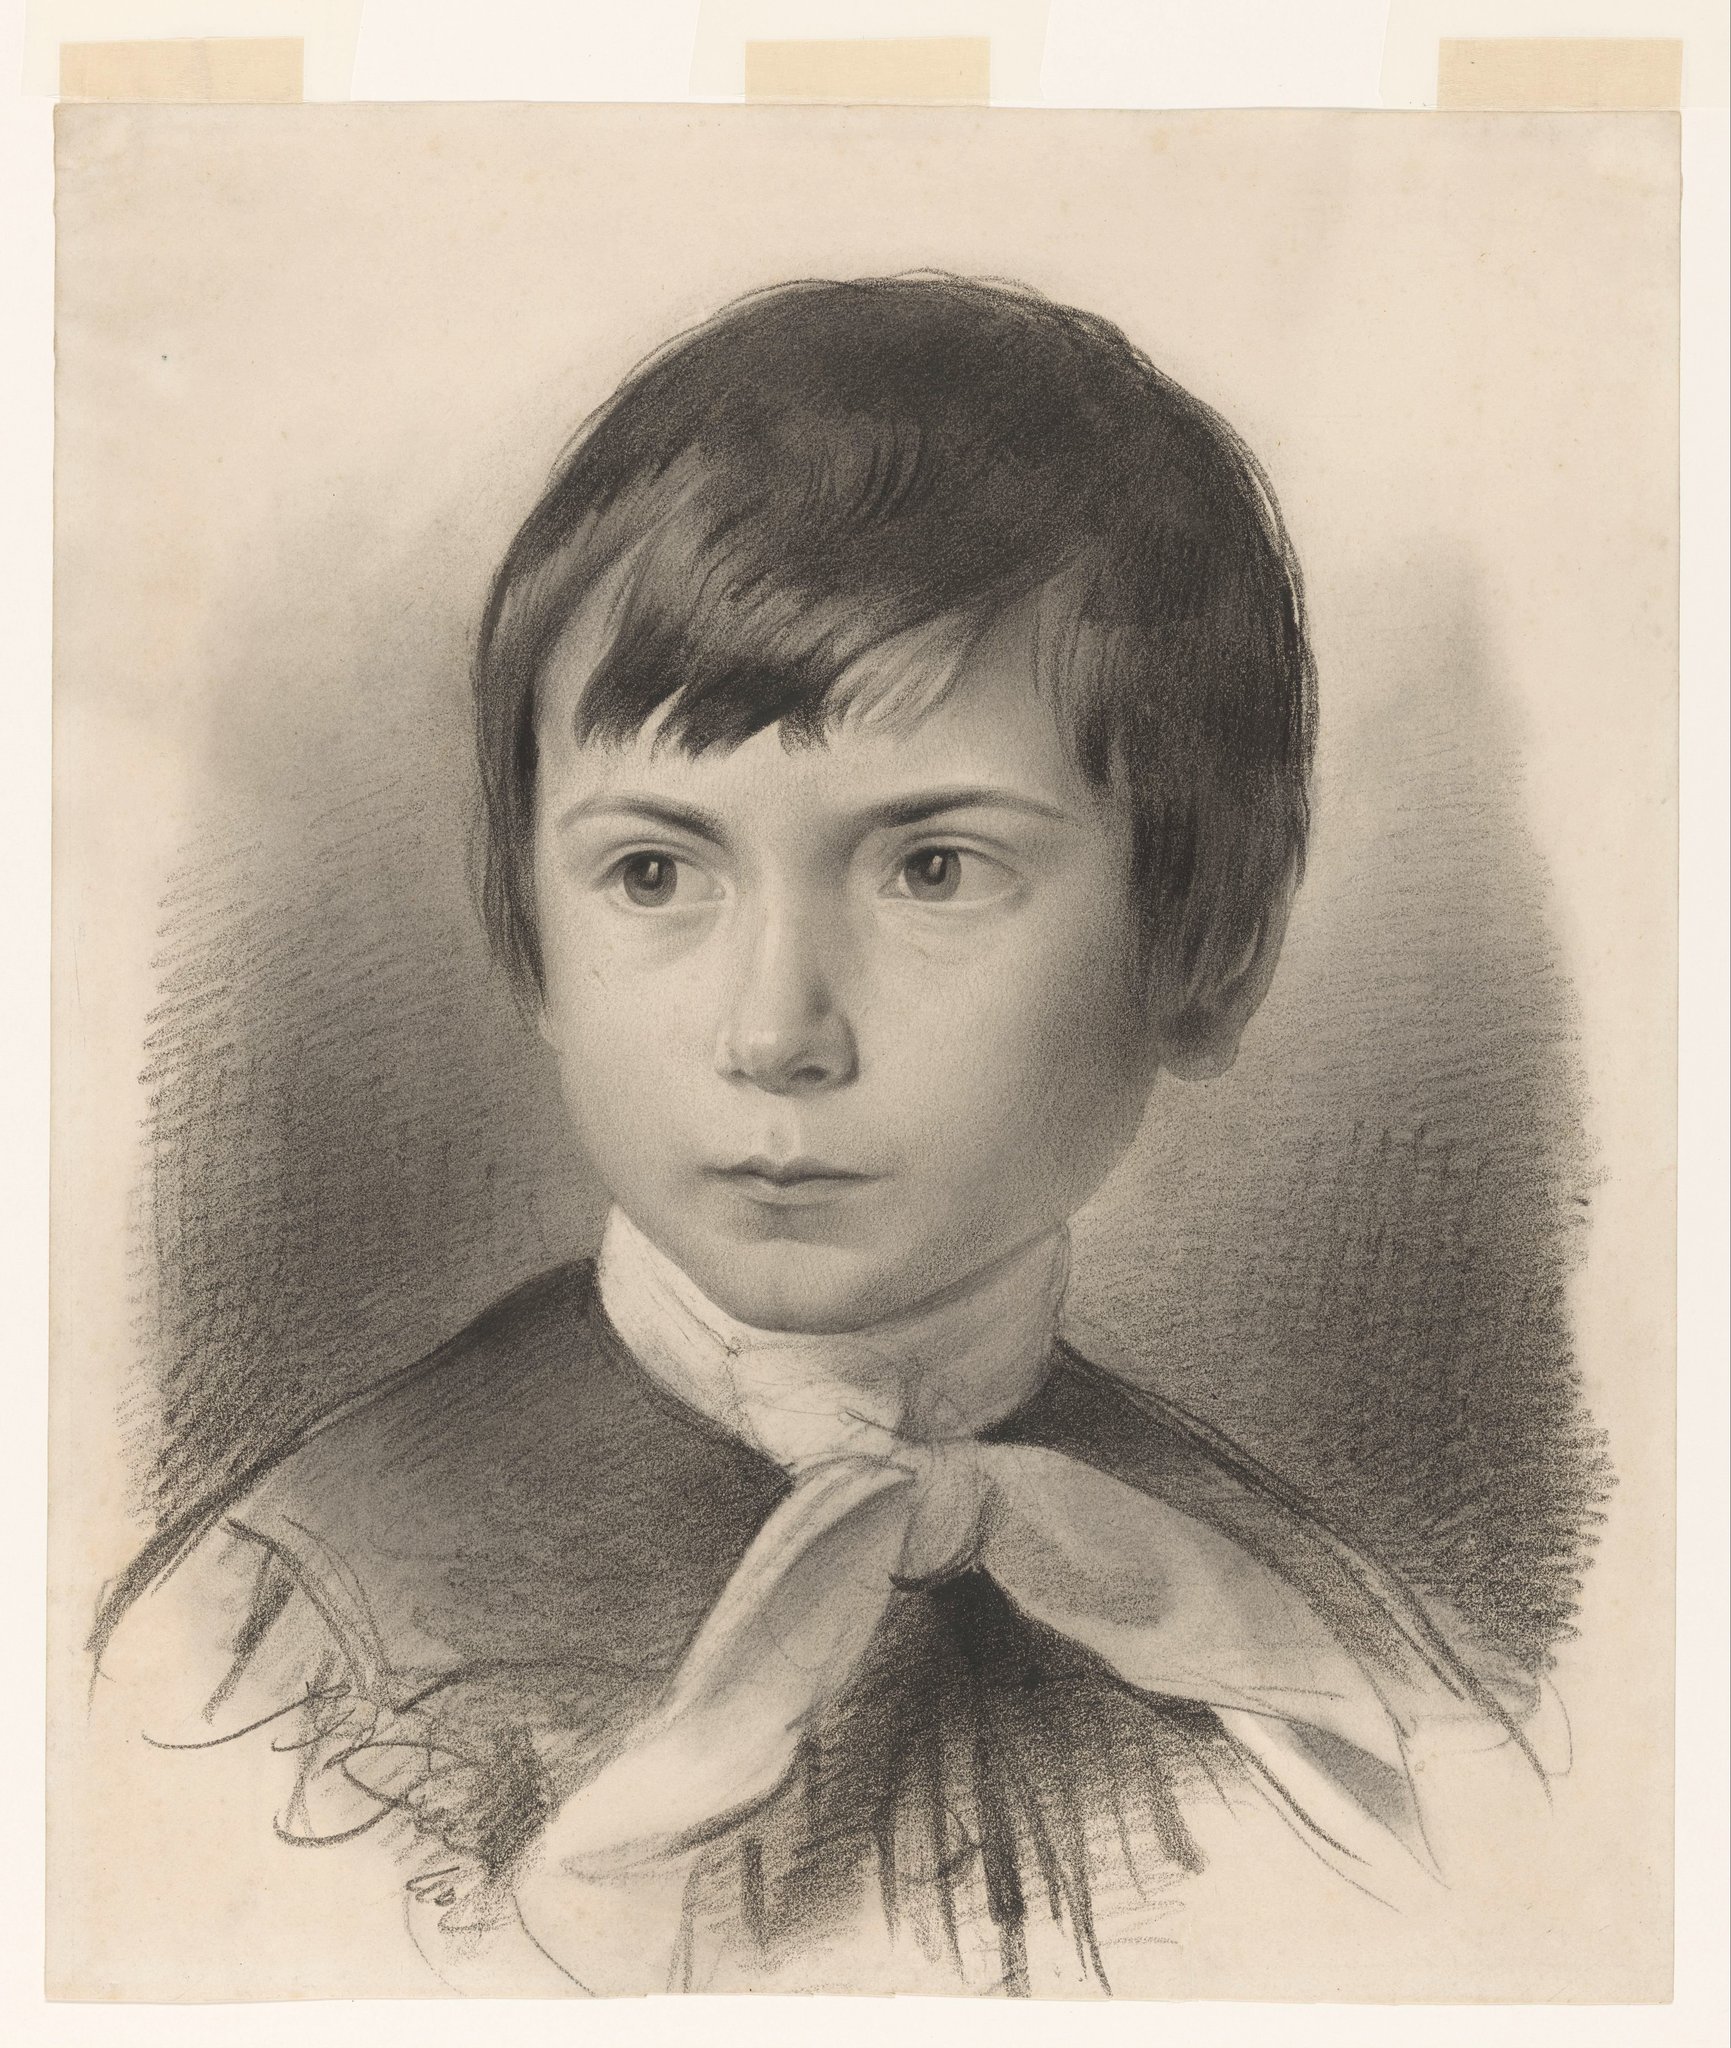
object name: drawing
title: Portret van Johan Daniël Koelman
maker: johan philip koelman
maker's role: draughtsman, painter, print maker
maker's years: 1818-1893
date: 1806-1840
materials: chalk, paper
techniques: stumping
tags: the hague, print maker, draughtsman, johan daniël koelman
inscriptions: monogram and date: ‘JPK / 40’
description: Portret van het broertje van Johan Philip Koelman, de latere kunstenaar Johan Daniël Koelman.